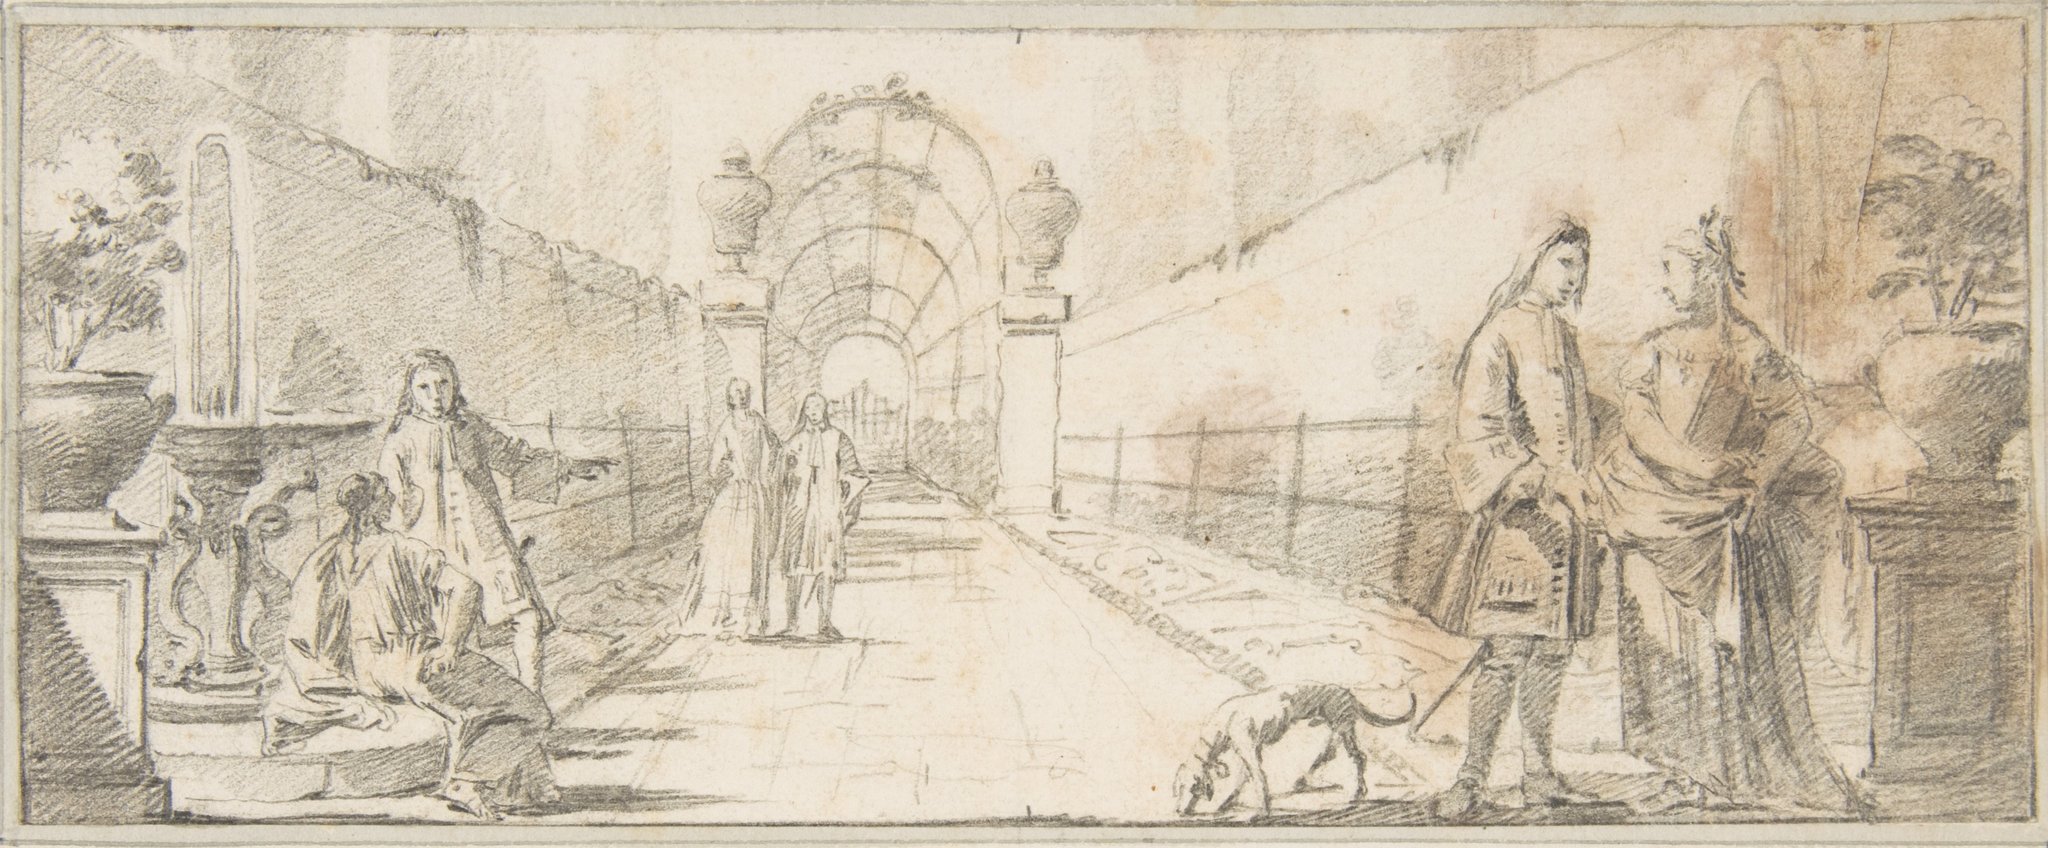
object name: drawing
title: Illustration for a Book: Figures in Conversation in a Garden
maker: giovanni battista tiepolo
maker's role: artist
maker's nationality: italian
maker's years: 1696-1770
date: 1696-1770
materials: chalk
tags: gardens,men,women,dogs